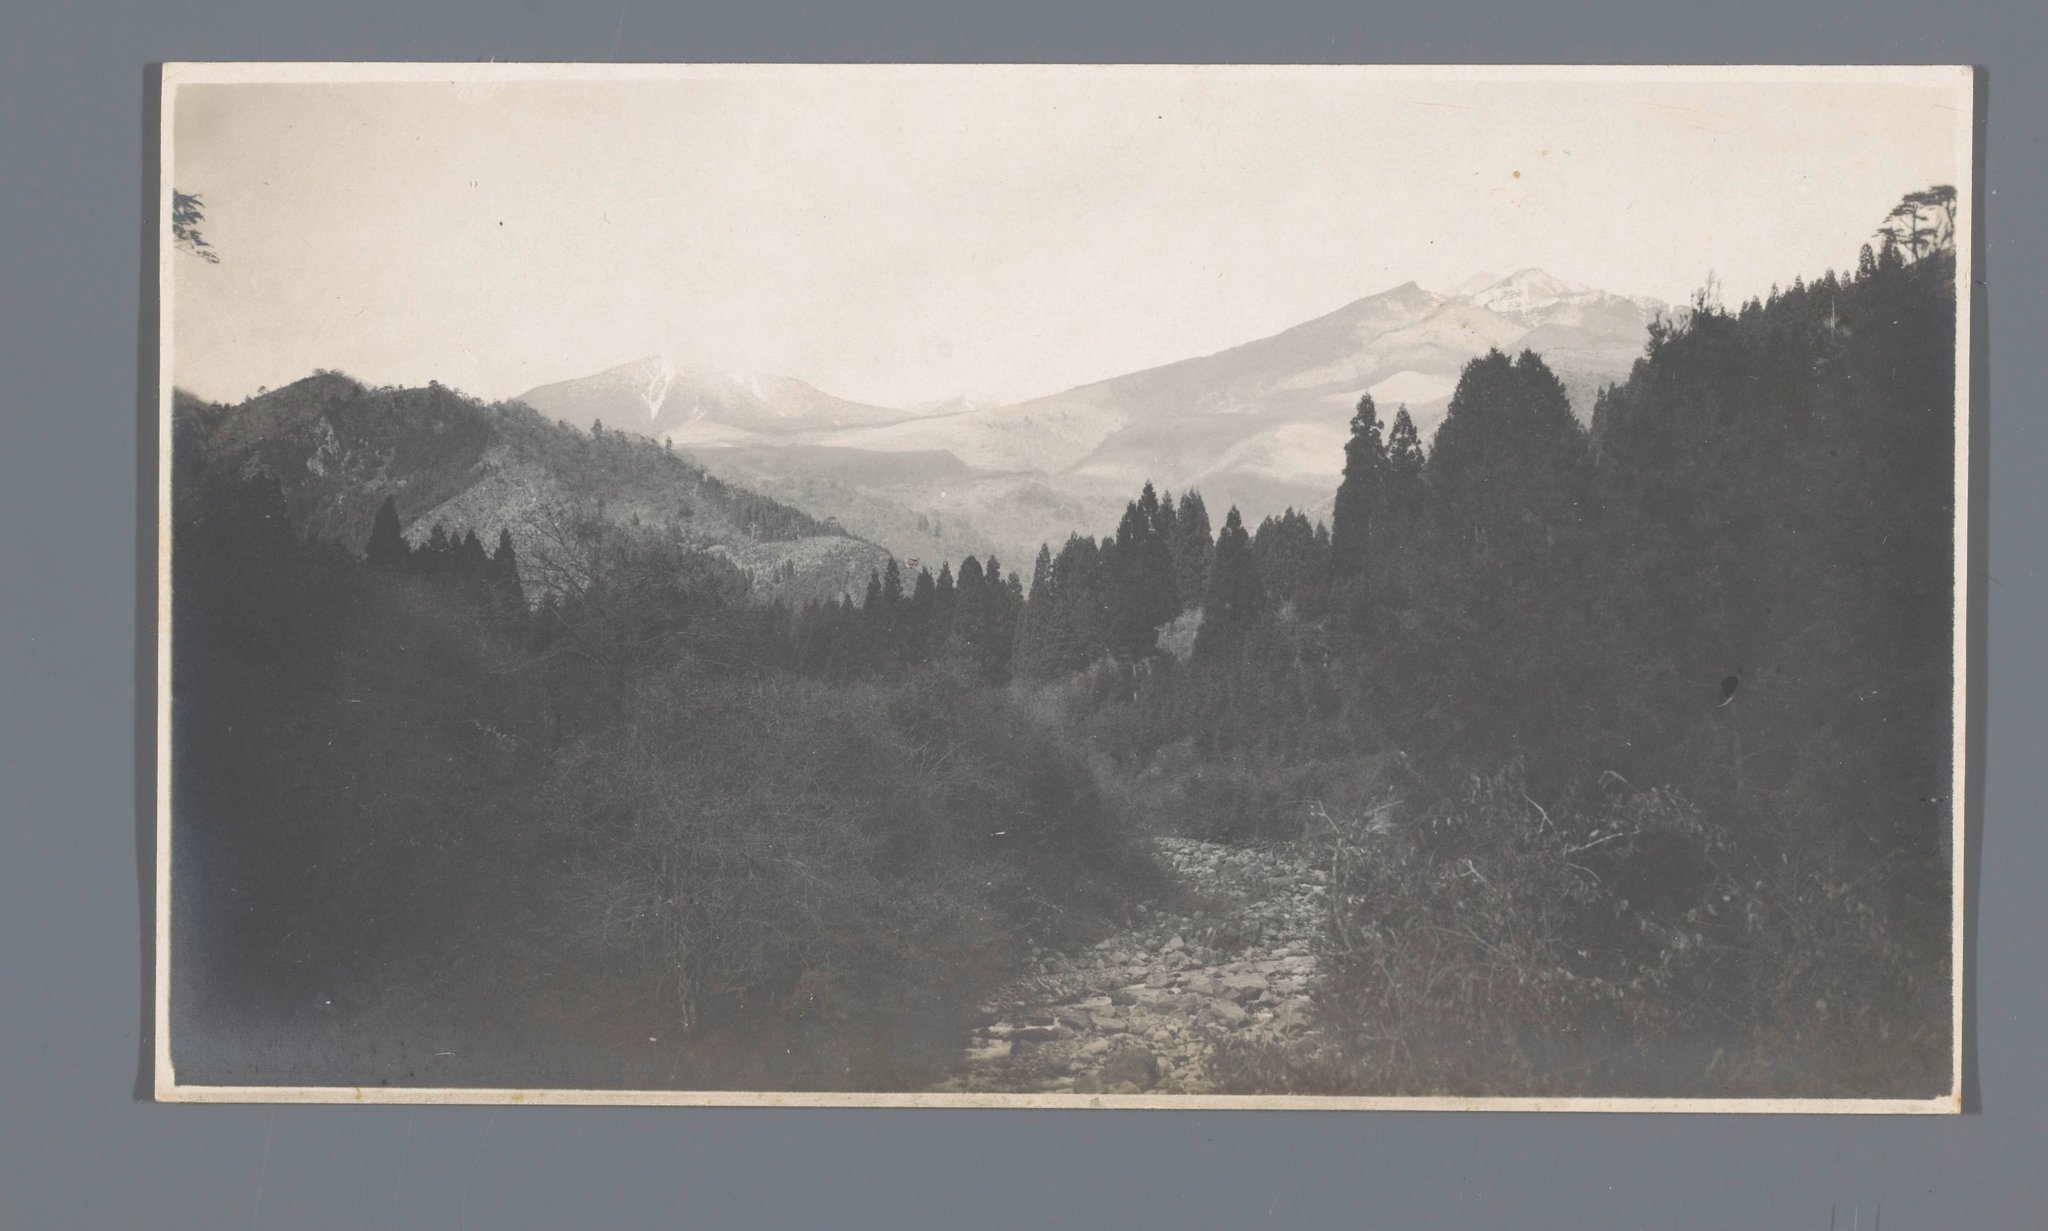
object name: photograph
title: Bergachtig landschap met bossen, Nikko, Japan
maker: jan adriani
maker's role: fotograaf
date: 1907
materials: paper, photographic support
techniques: gelatin silver print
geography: japan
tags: forest, wood, mountains